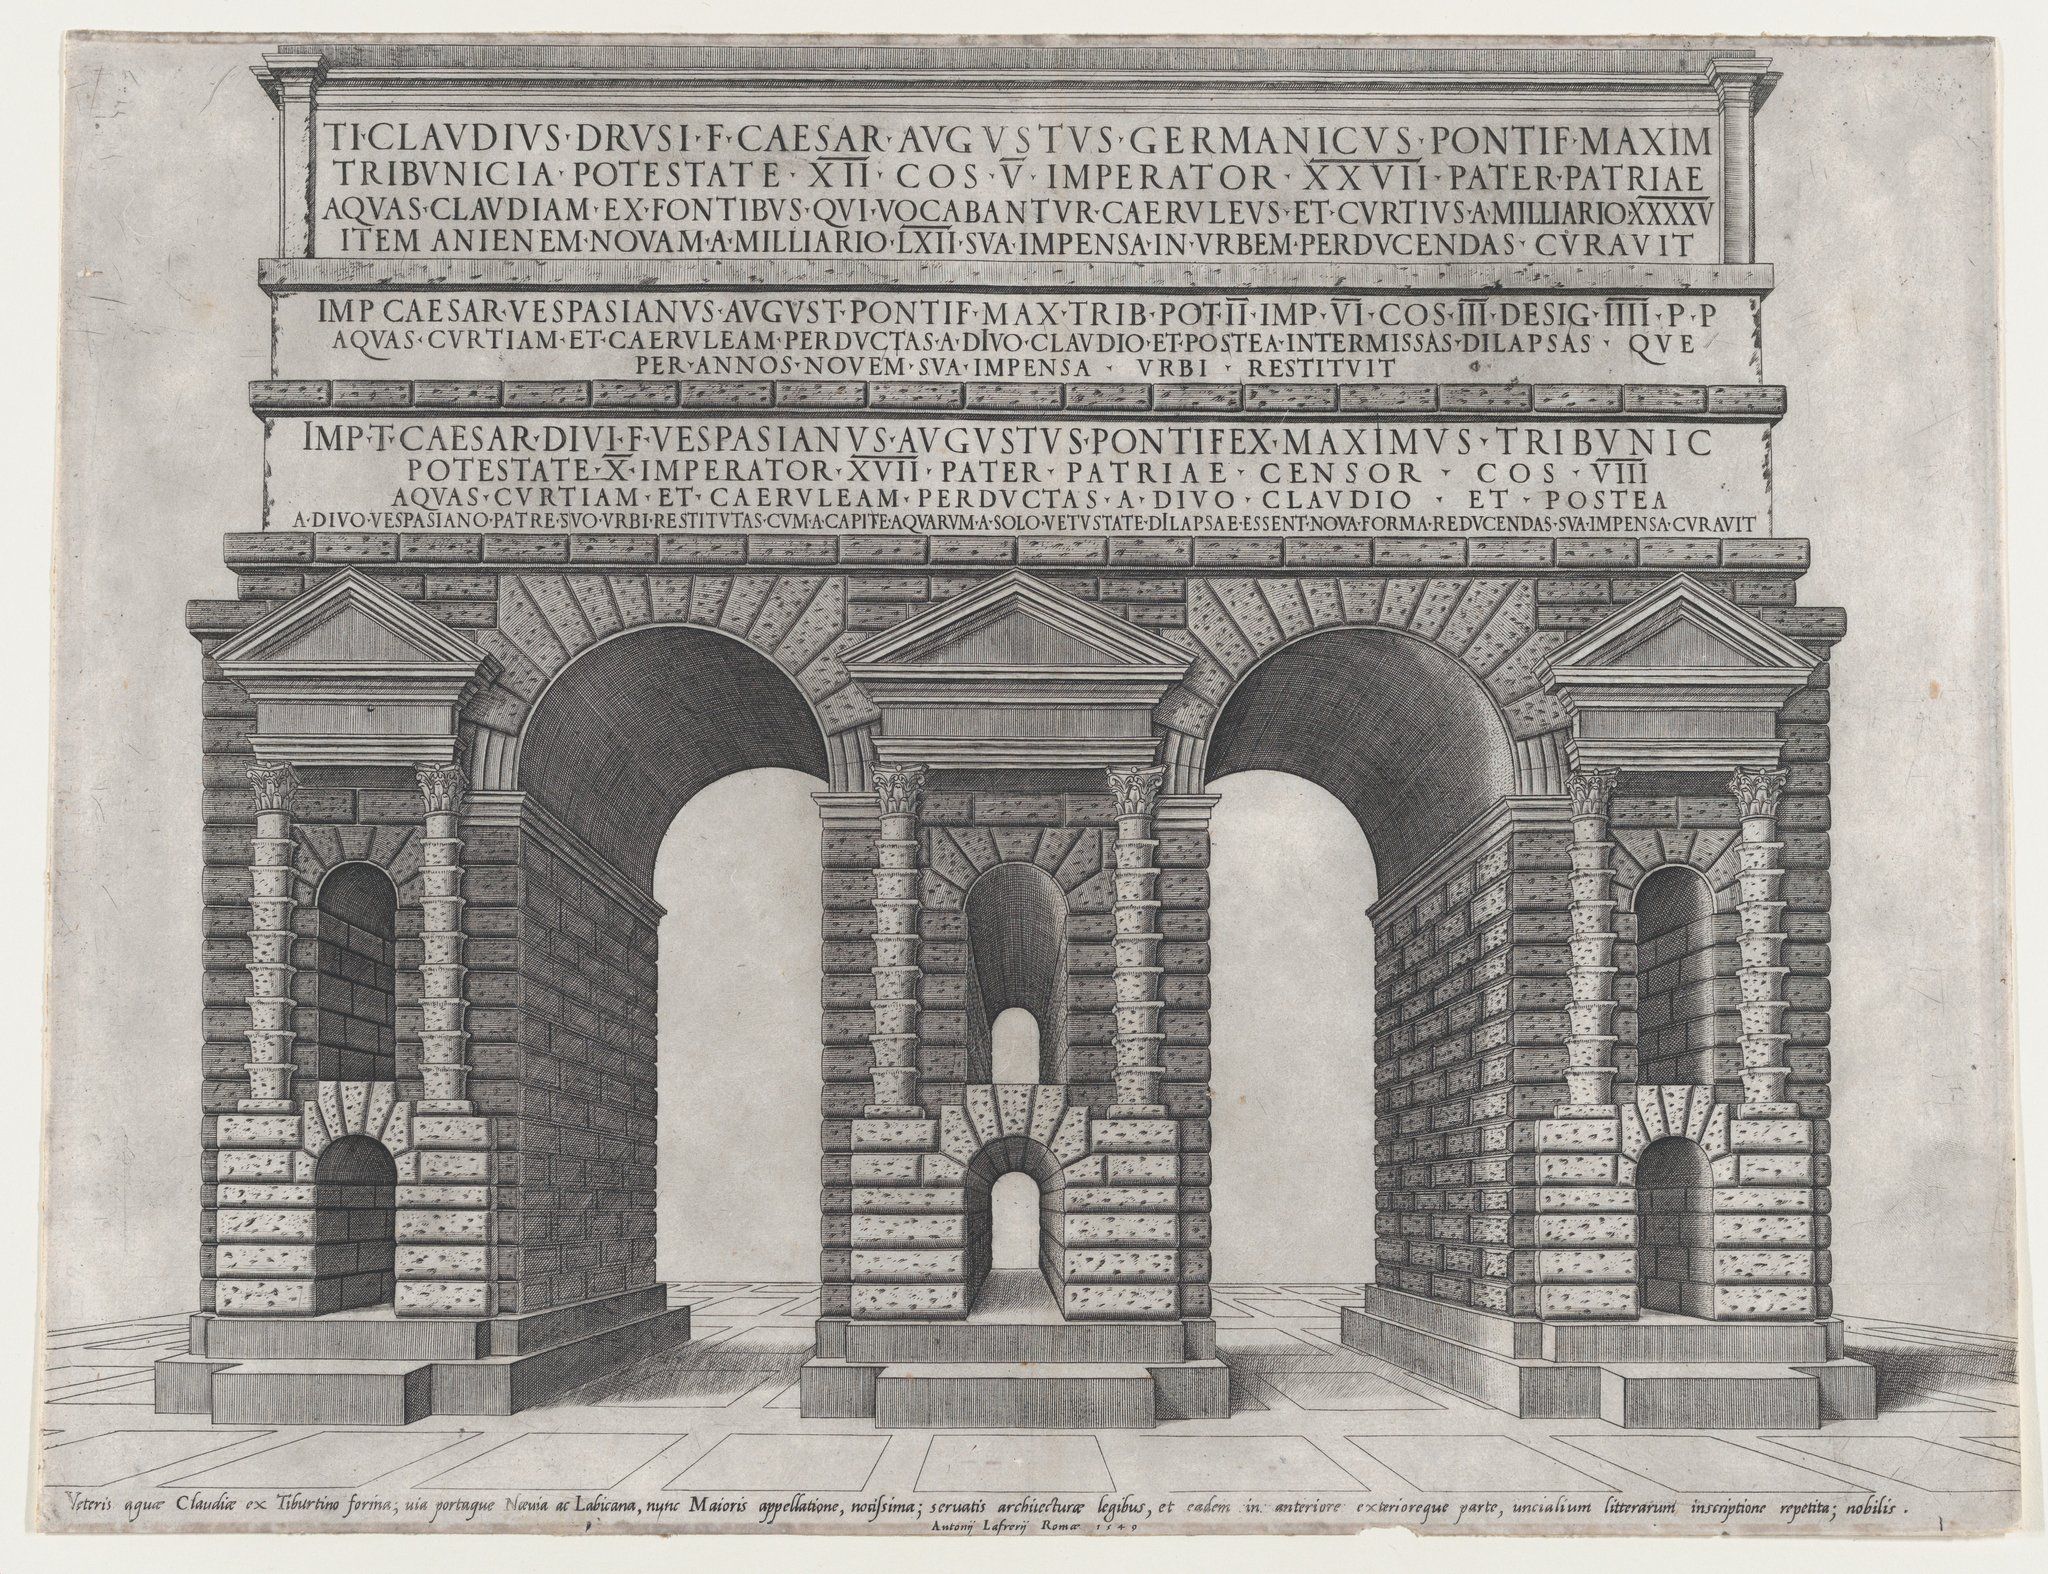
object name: print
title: Porta Maggiore, from "Speculum Romanae Magnificentiae"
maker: Anonymous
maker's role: artist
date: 1549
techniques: engraving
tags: architecture,arches,rome